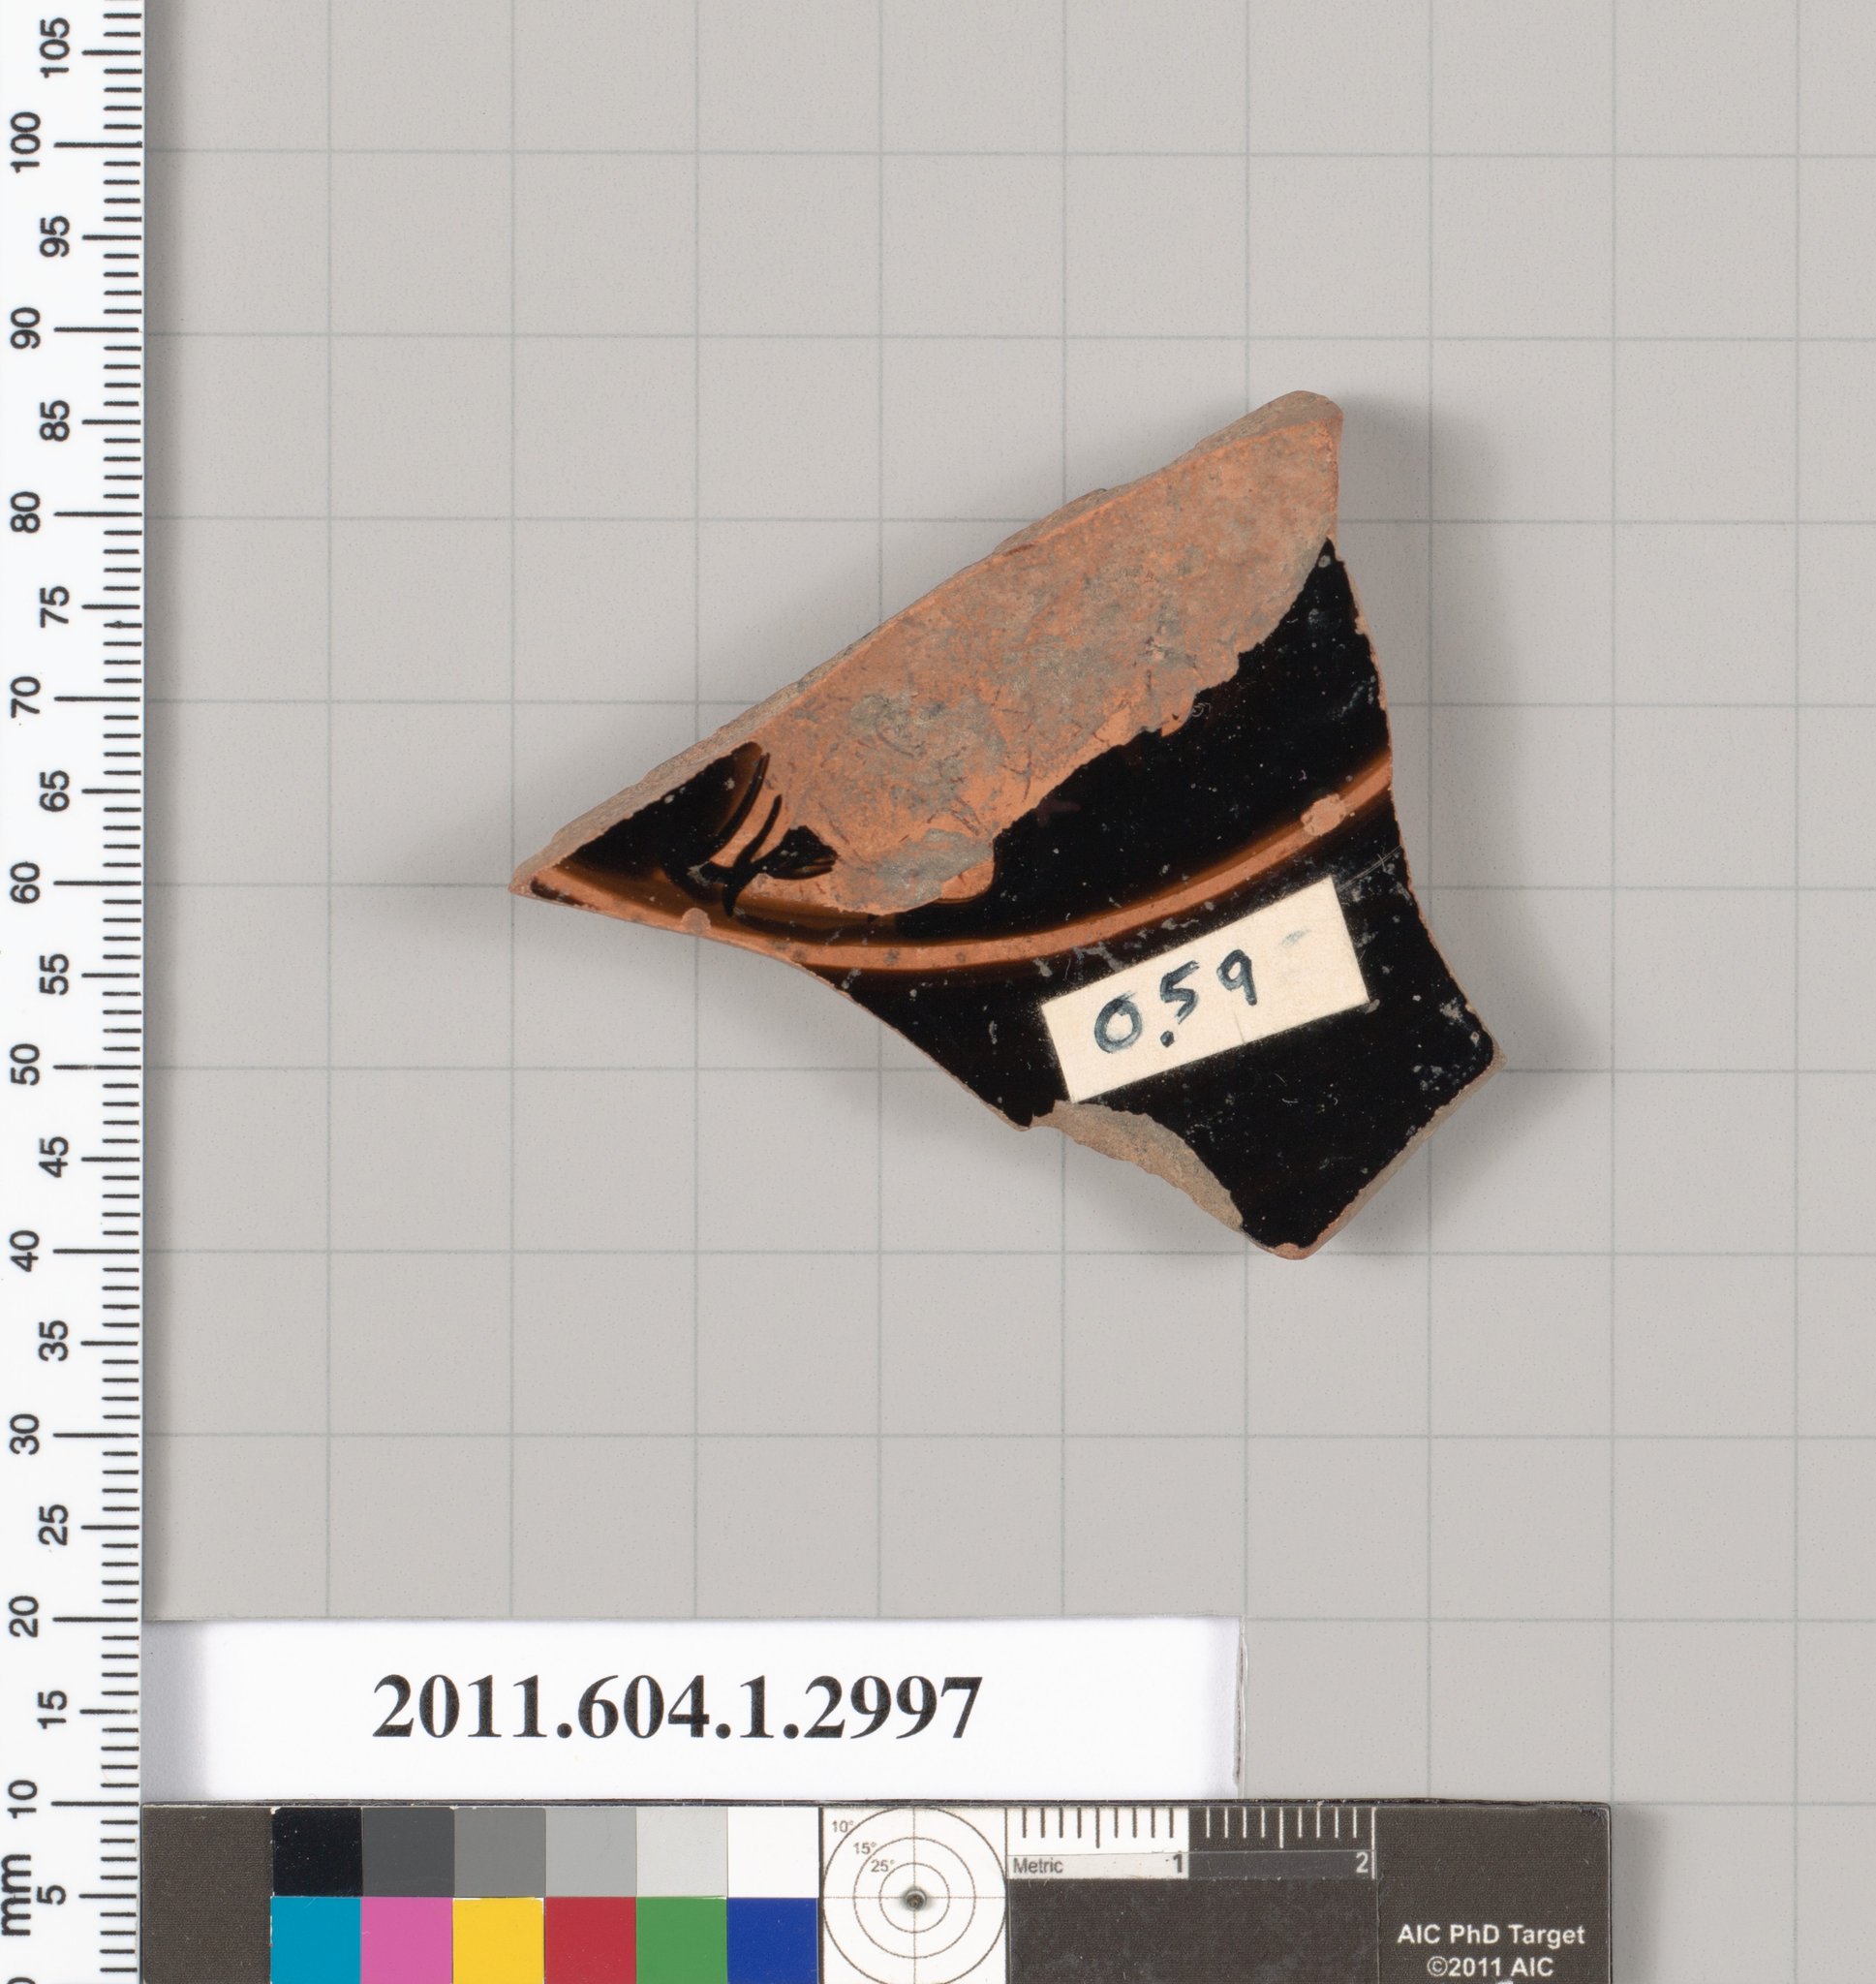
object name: kylix fragment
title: Terracotta fragment of a kylix (drinking cup)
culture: greek, attic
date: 520-500 BCE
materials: terracotta